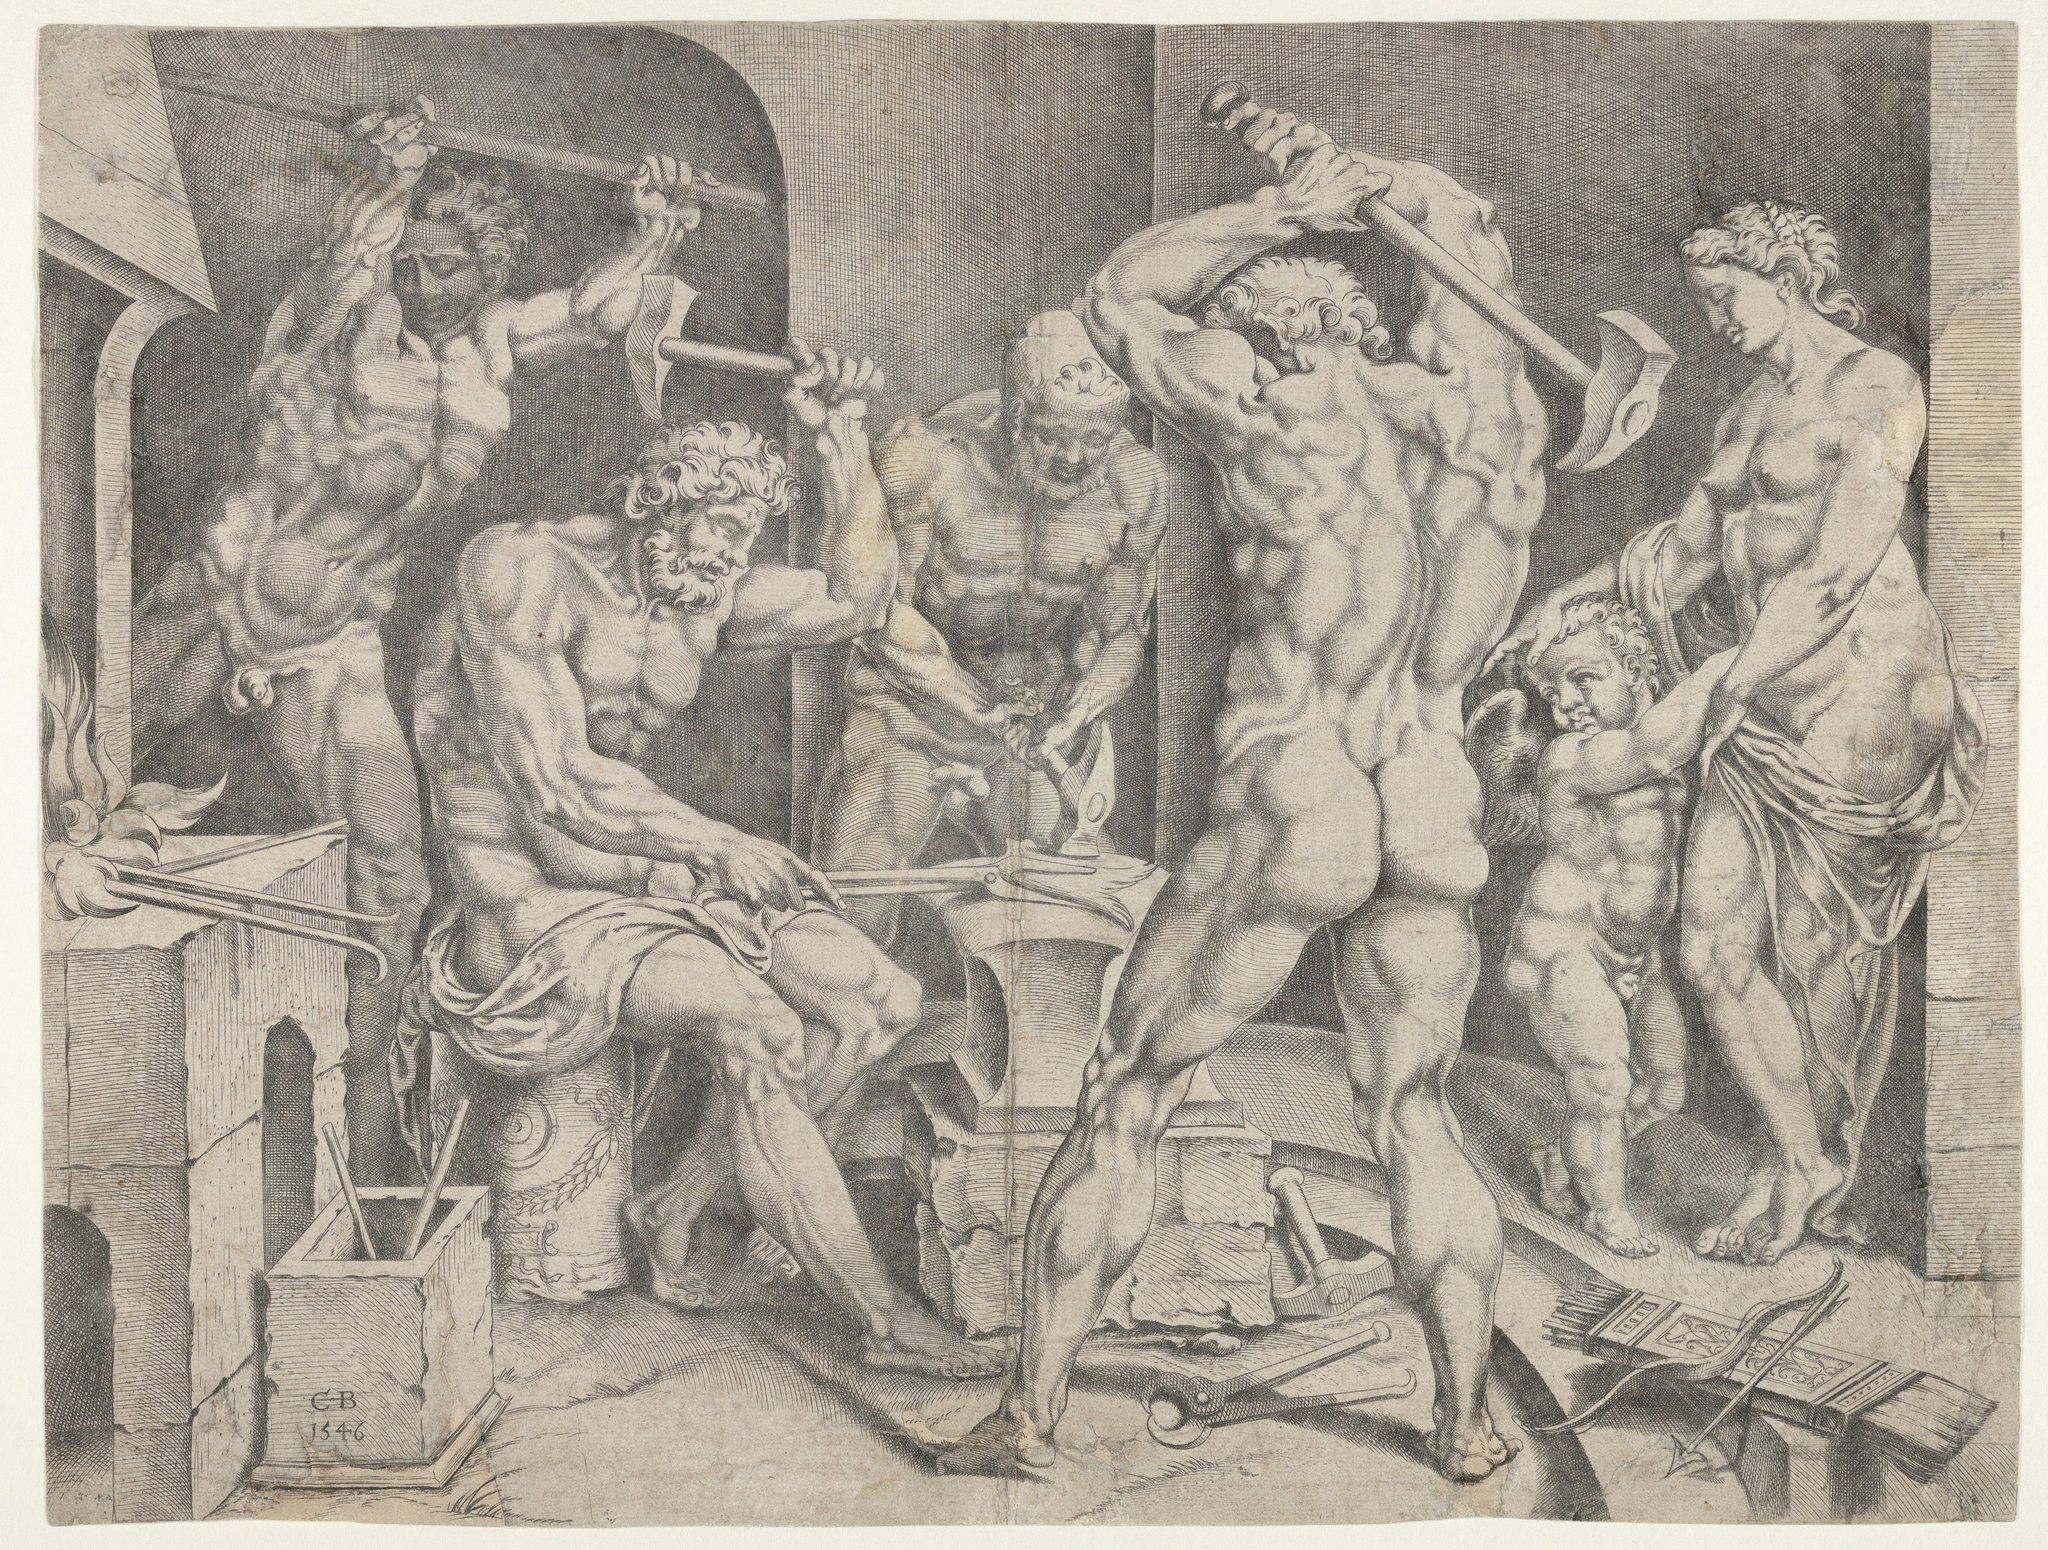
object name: print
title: The Forge of Vulcan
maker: cornelis bos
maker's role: artist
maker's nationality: netherlandish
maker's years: 1510-1556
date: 1546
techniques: engraving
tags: male nudes,female nudes,vulcan,hammers